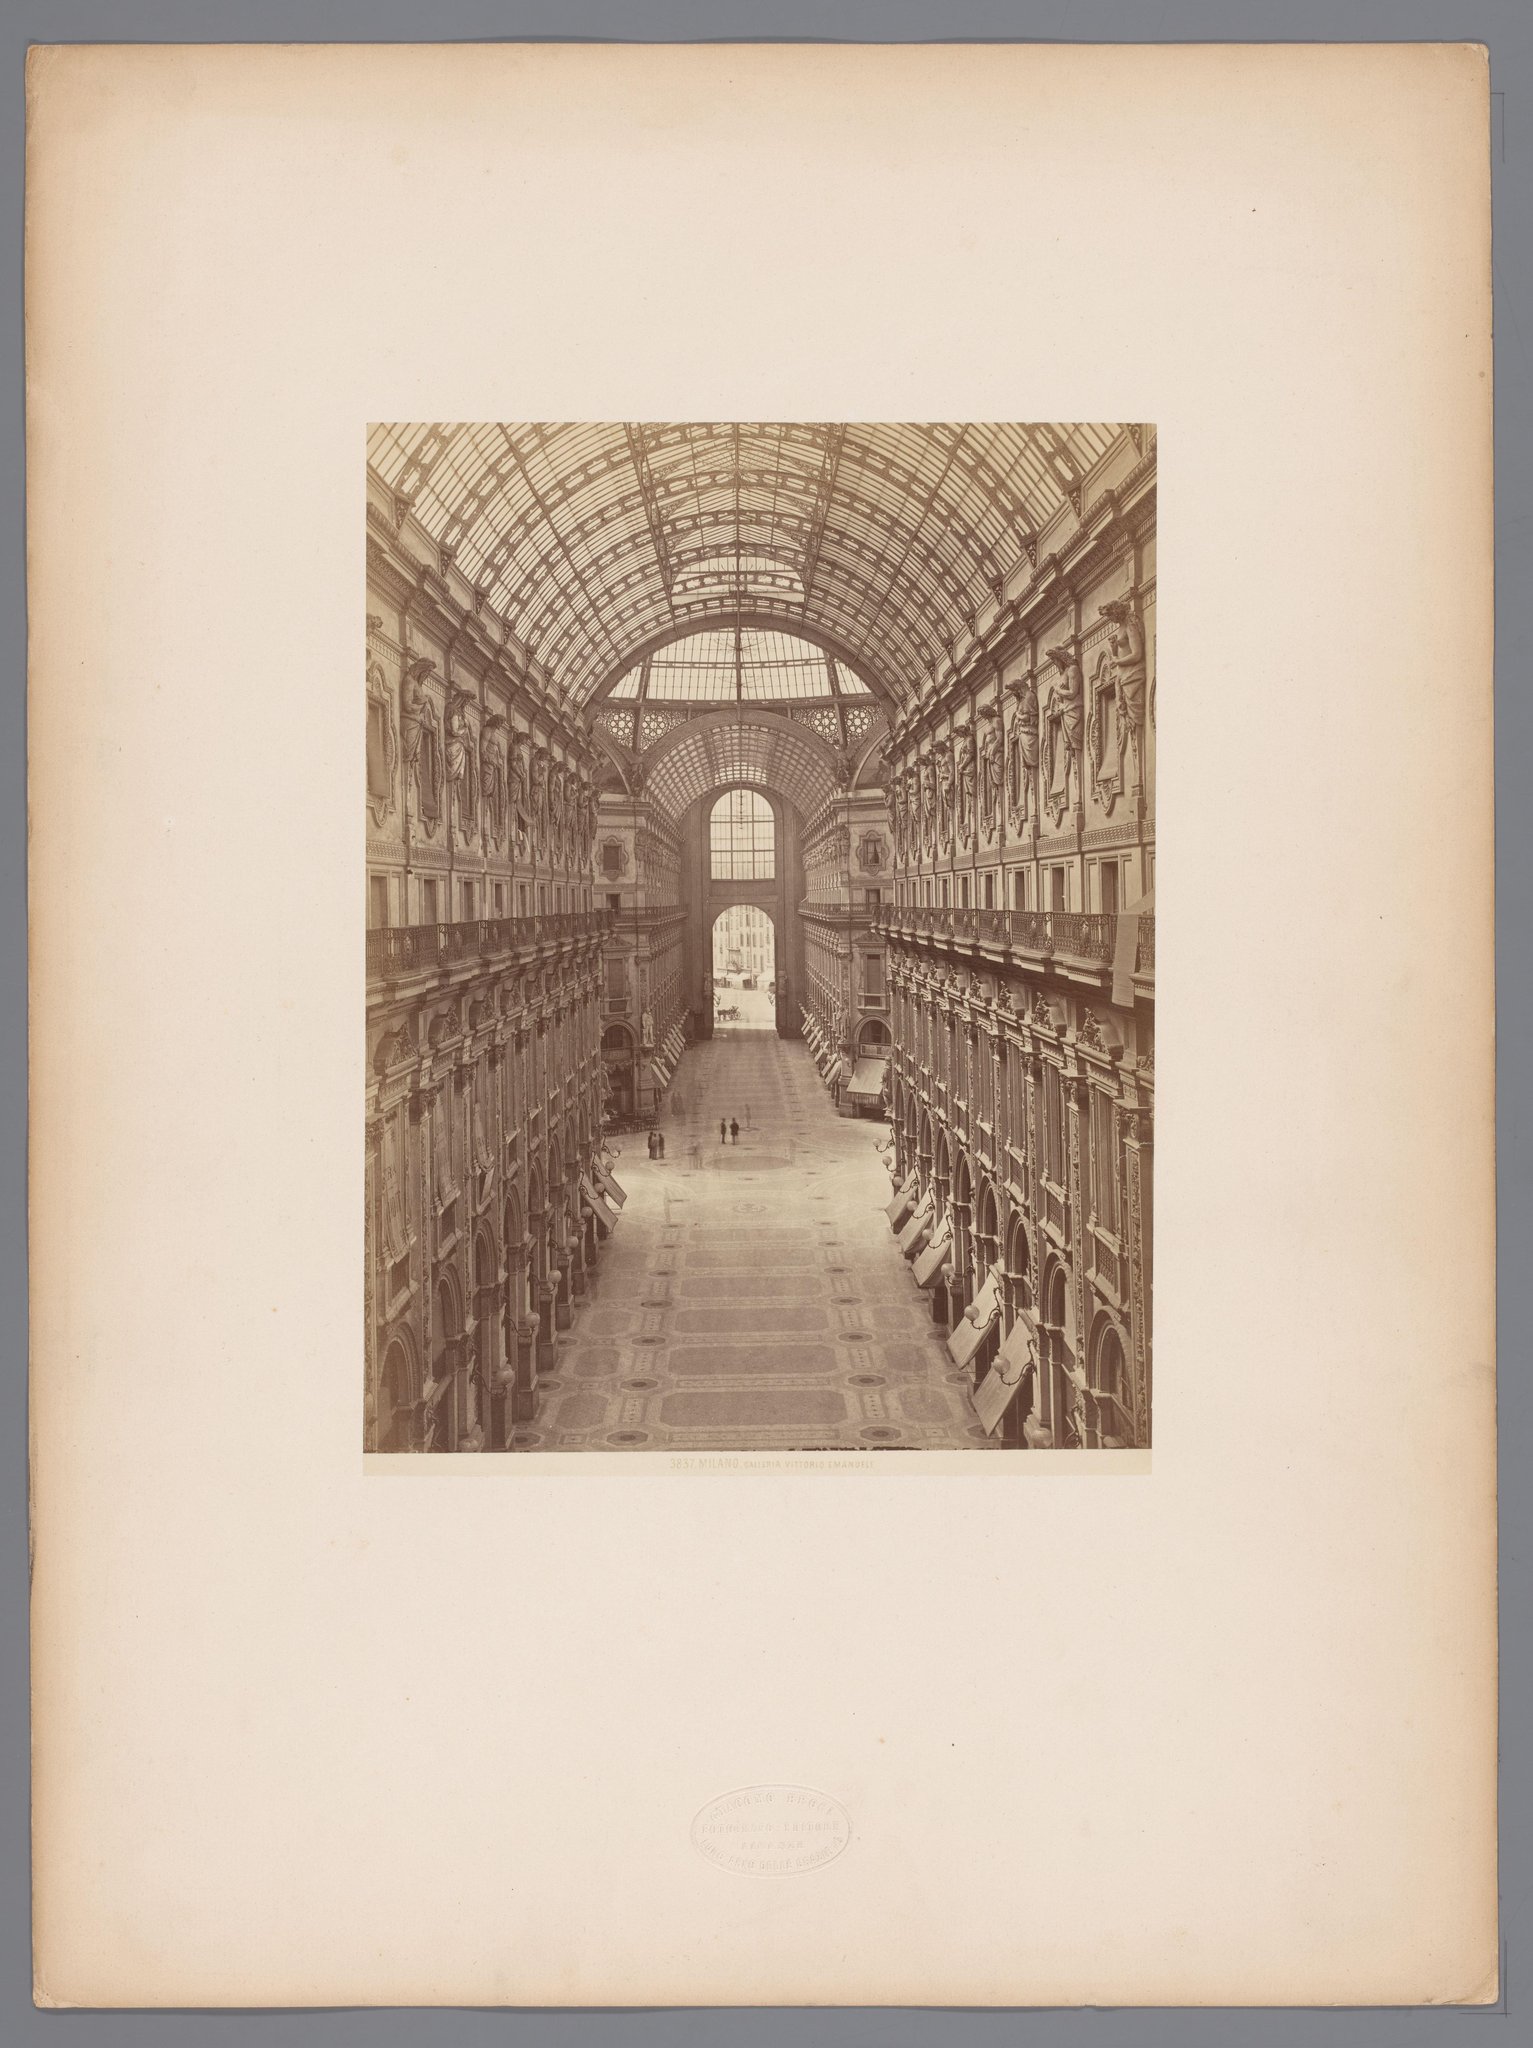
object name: photograph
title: Milano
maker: giacomo brogi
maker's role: fotograaf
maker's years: 1822-1881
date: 1878-1881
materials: cardboard, paper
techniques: albumen print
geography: florence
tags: gallery (spacious corridor)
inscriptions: address: ‘GIACOMO BROGI/ FOTOGRAFO-EDITORE/ FIRENZE/ LUNG ARNO DELLE GRAZIE 15’, number: ‘3837.’